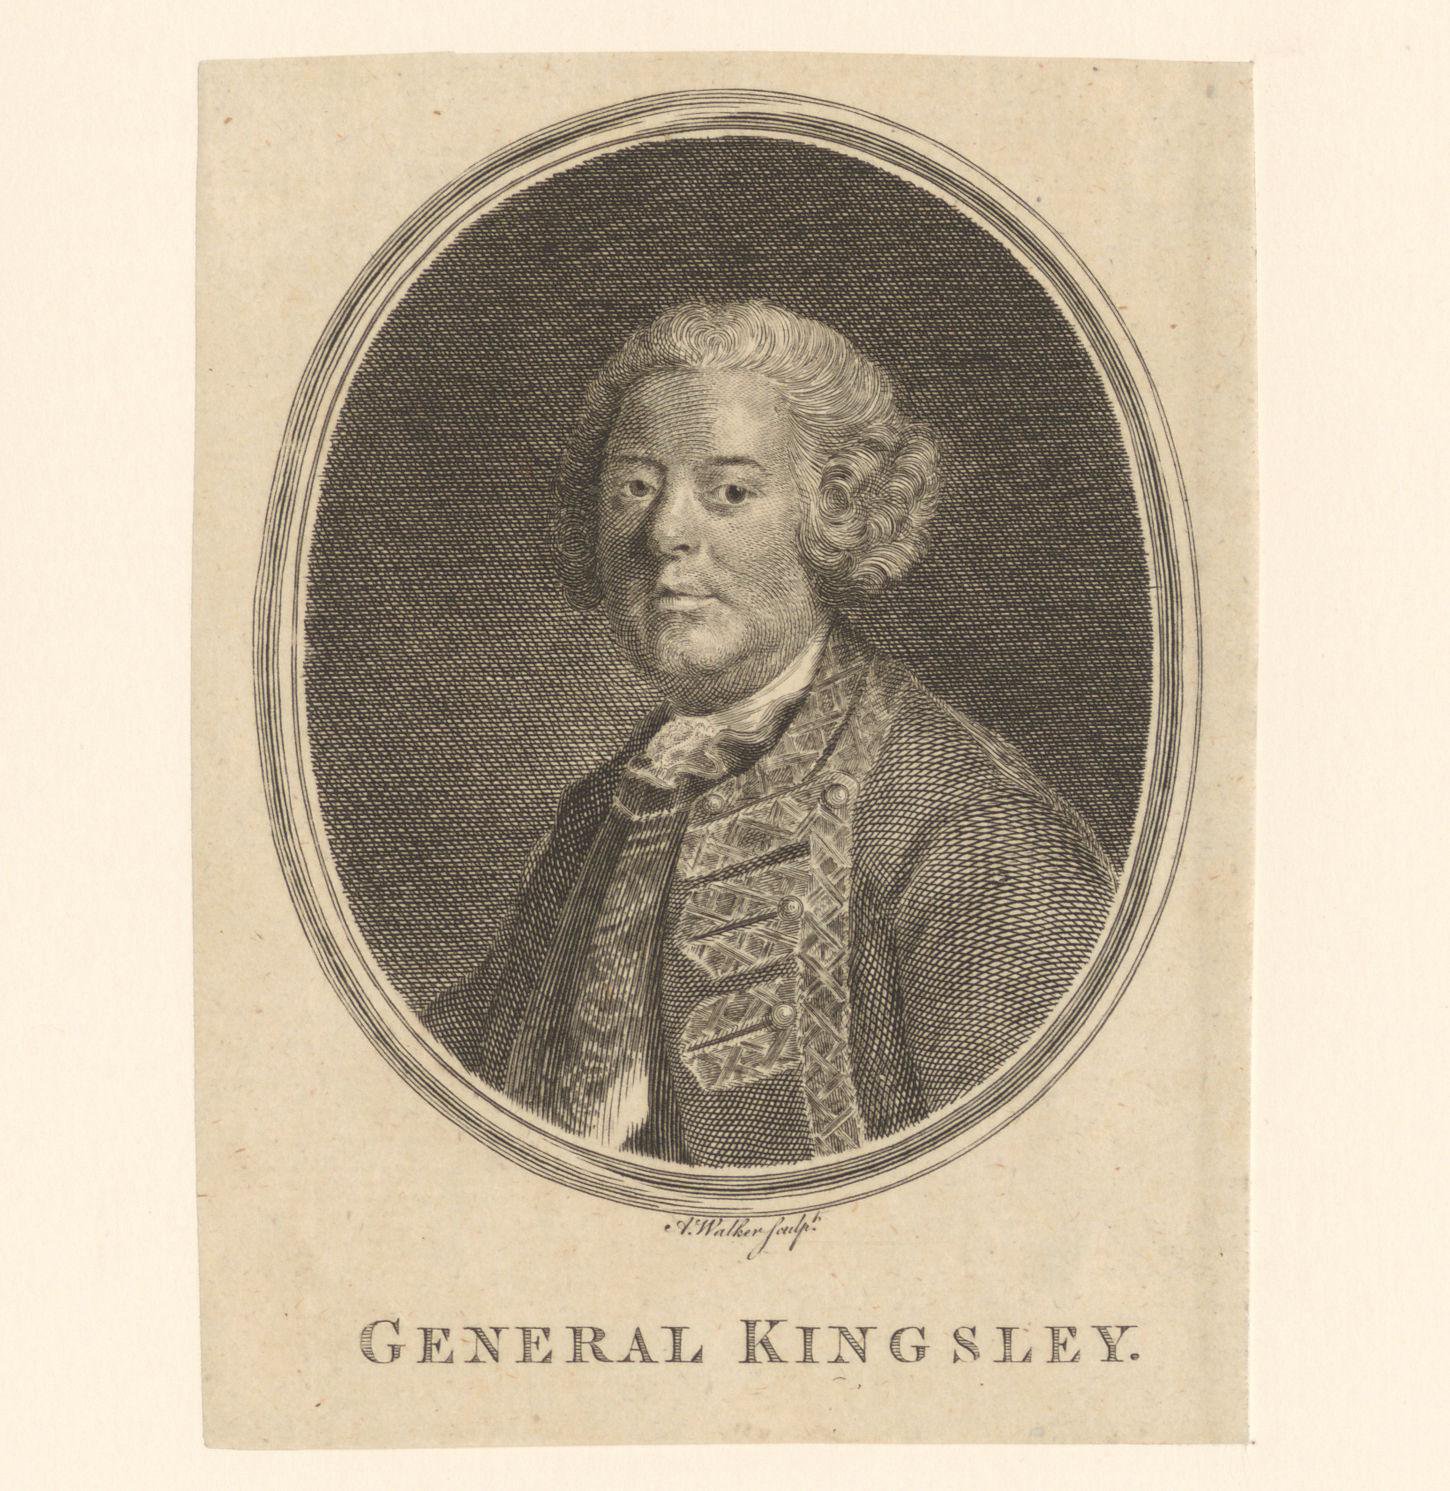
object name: print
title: Portret van William Kingsley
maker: anthony walker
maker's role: print maker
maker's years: 1726-1765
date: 1736-1765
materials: paper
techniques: engraving, etching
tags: historical persons, officer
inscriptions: collector's mark: Lugt 2228